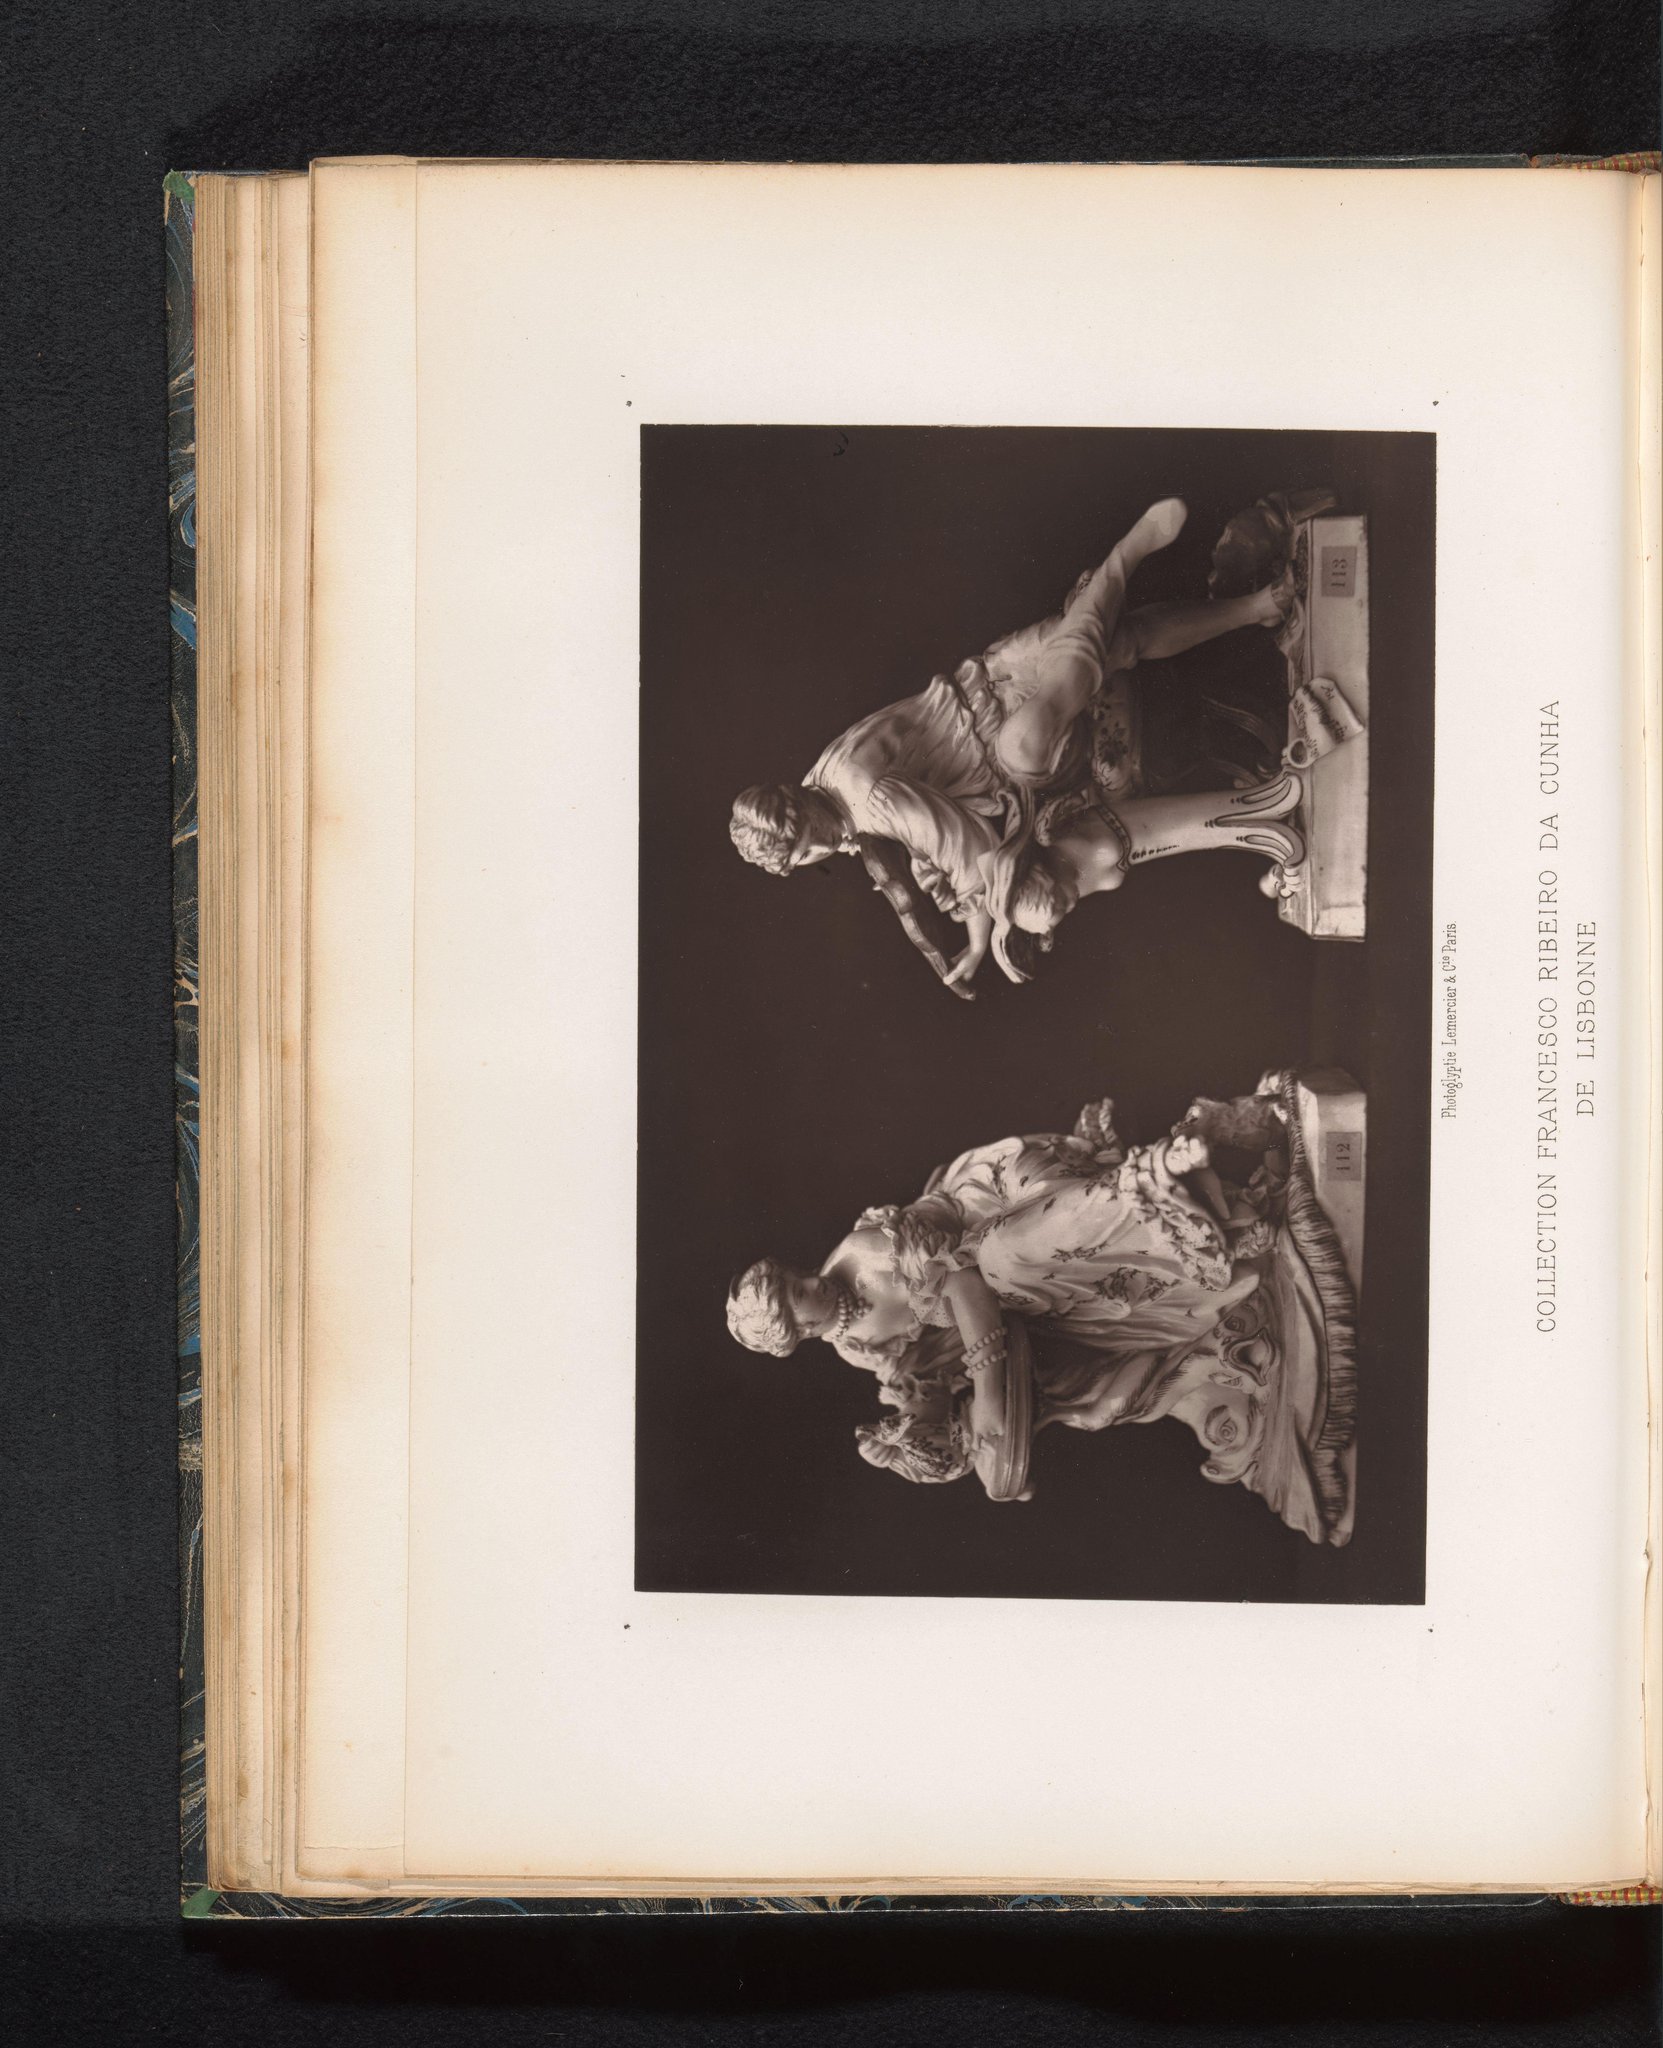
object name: page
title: Twee sculpturen van een vrouw die thee drinkt en een violiste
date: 1879-1884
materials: paper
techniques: woodburytype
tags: violin, fiddle, sculpture, cup of tea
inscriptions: inscription: ‘Collection Francesco Riberio da Cunha de Lisbonne’